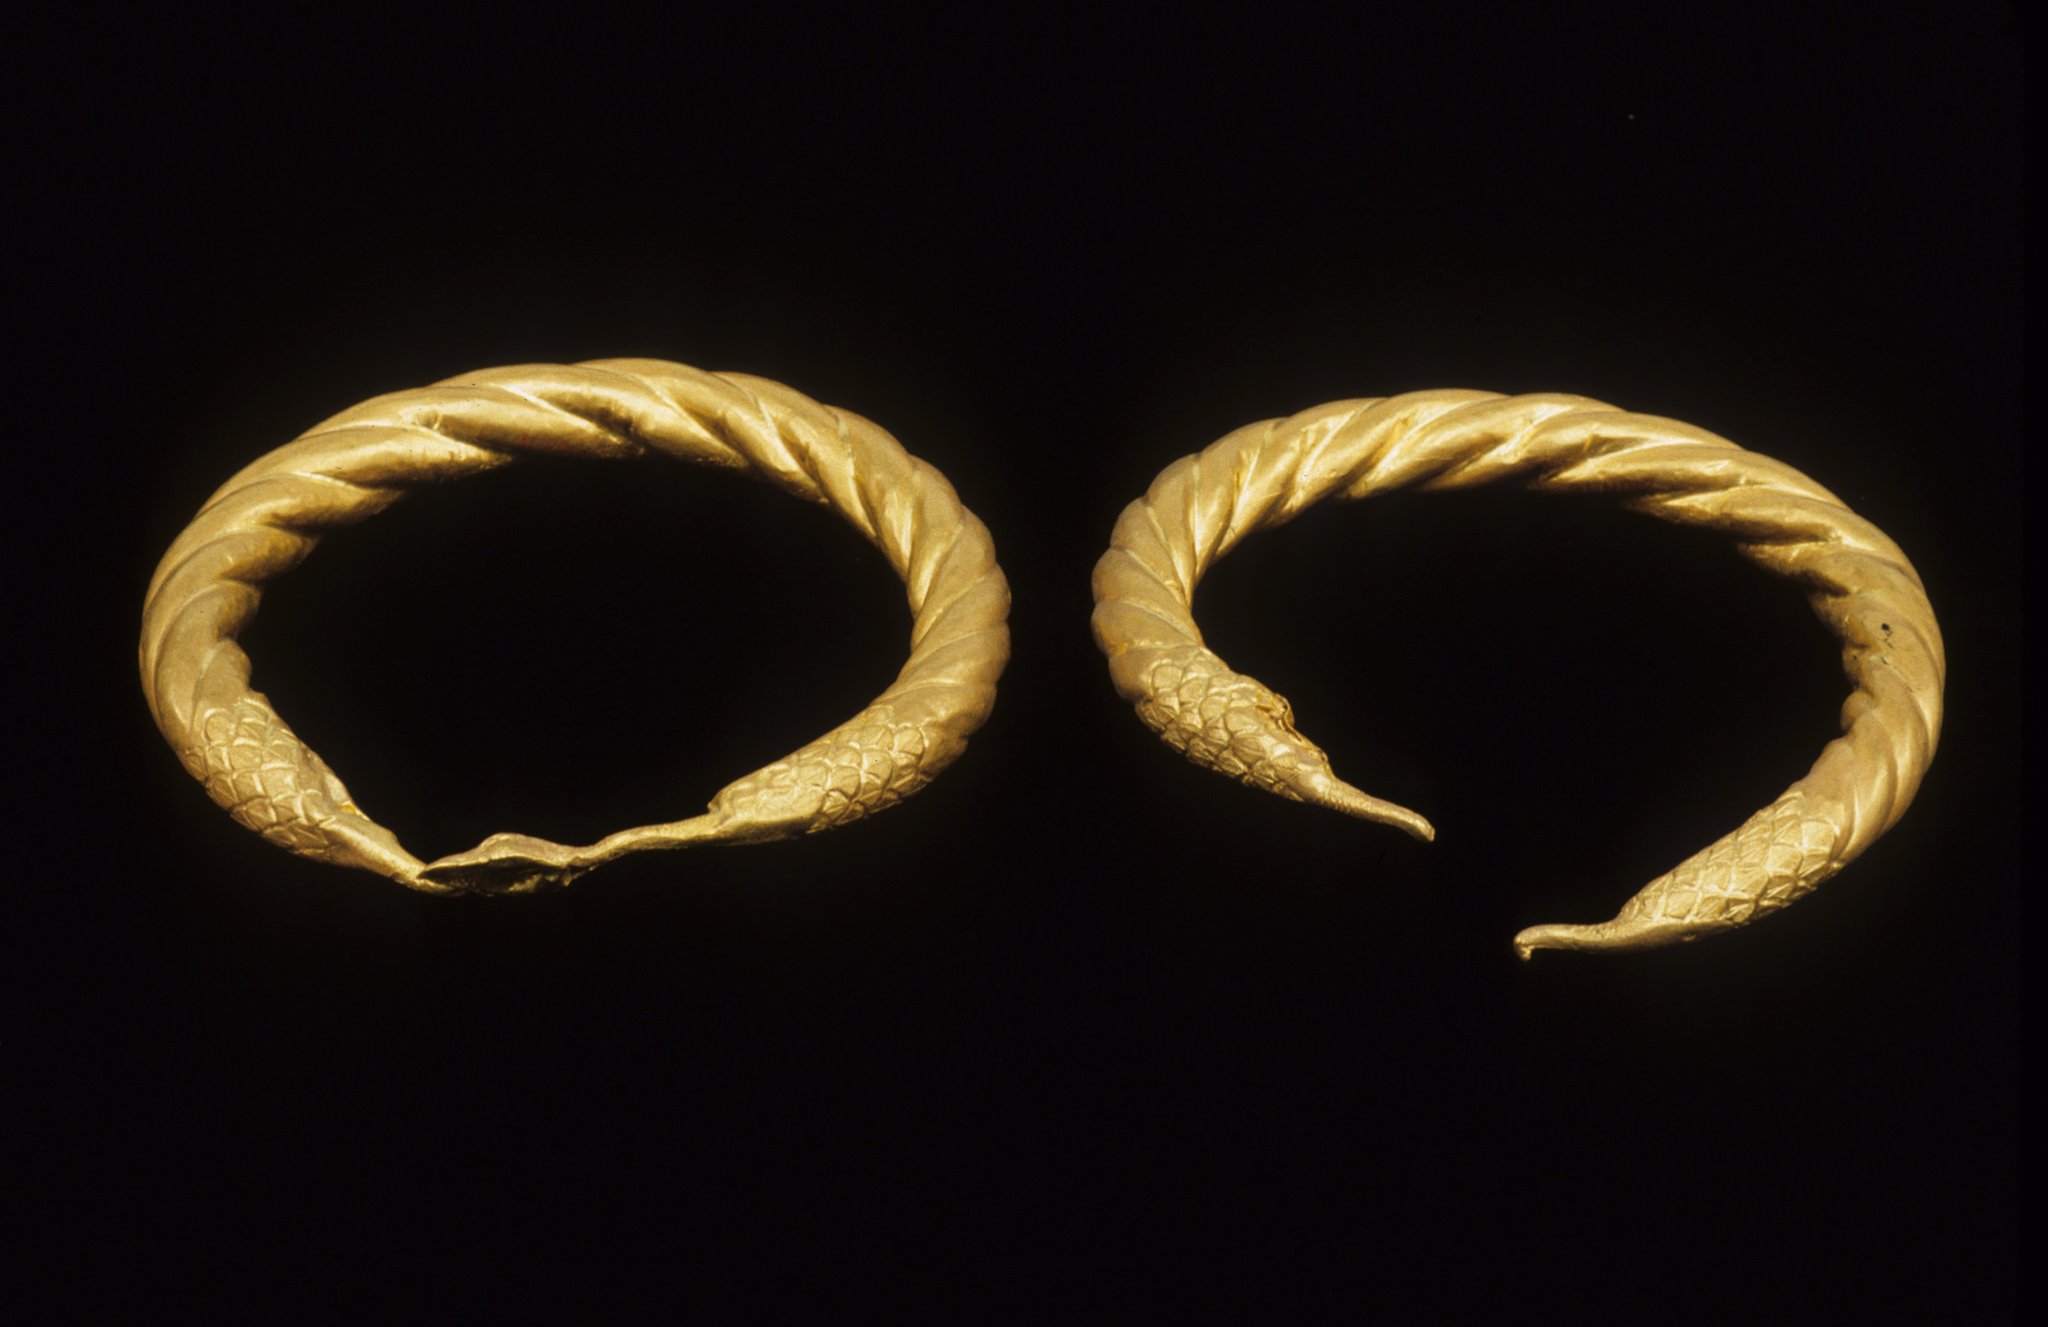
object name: armlet, goose terminal missing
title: Spirally twisted tubular armlet, former goose-head terminals missing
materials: gold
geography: memphite region